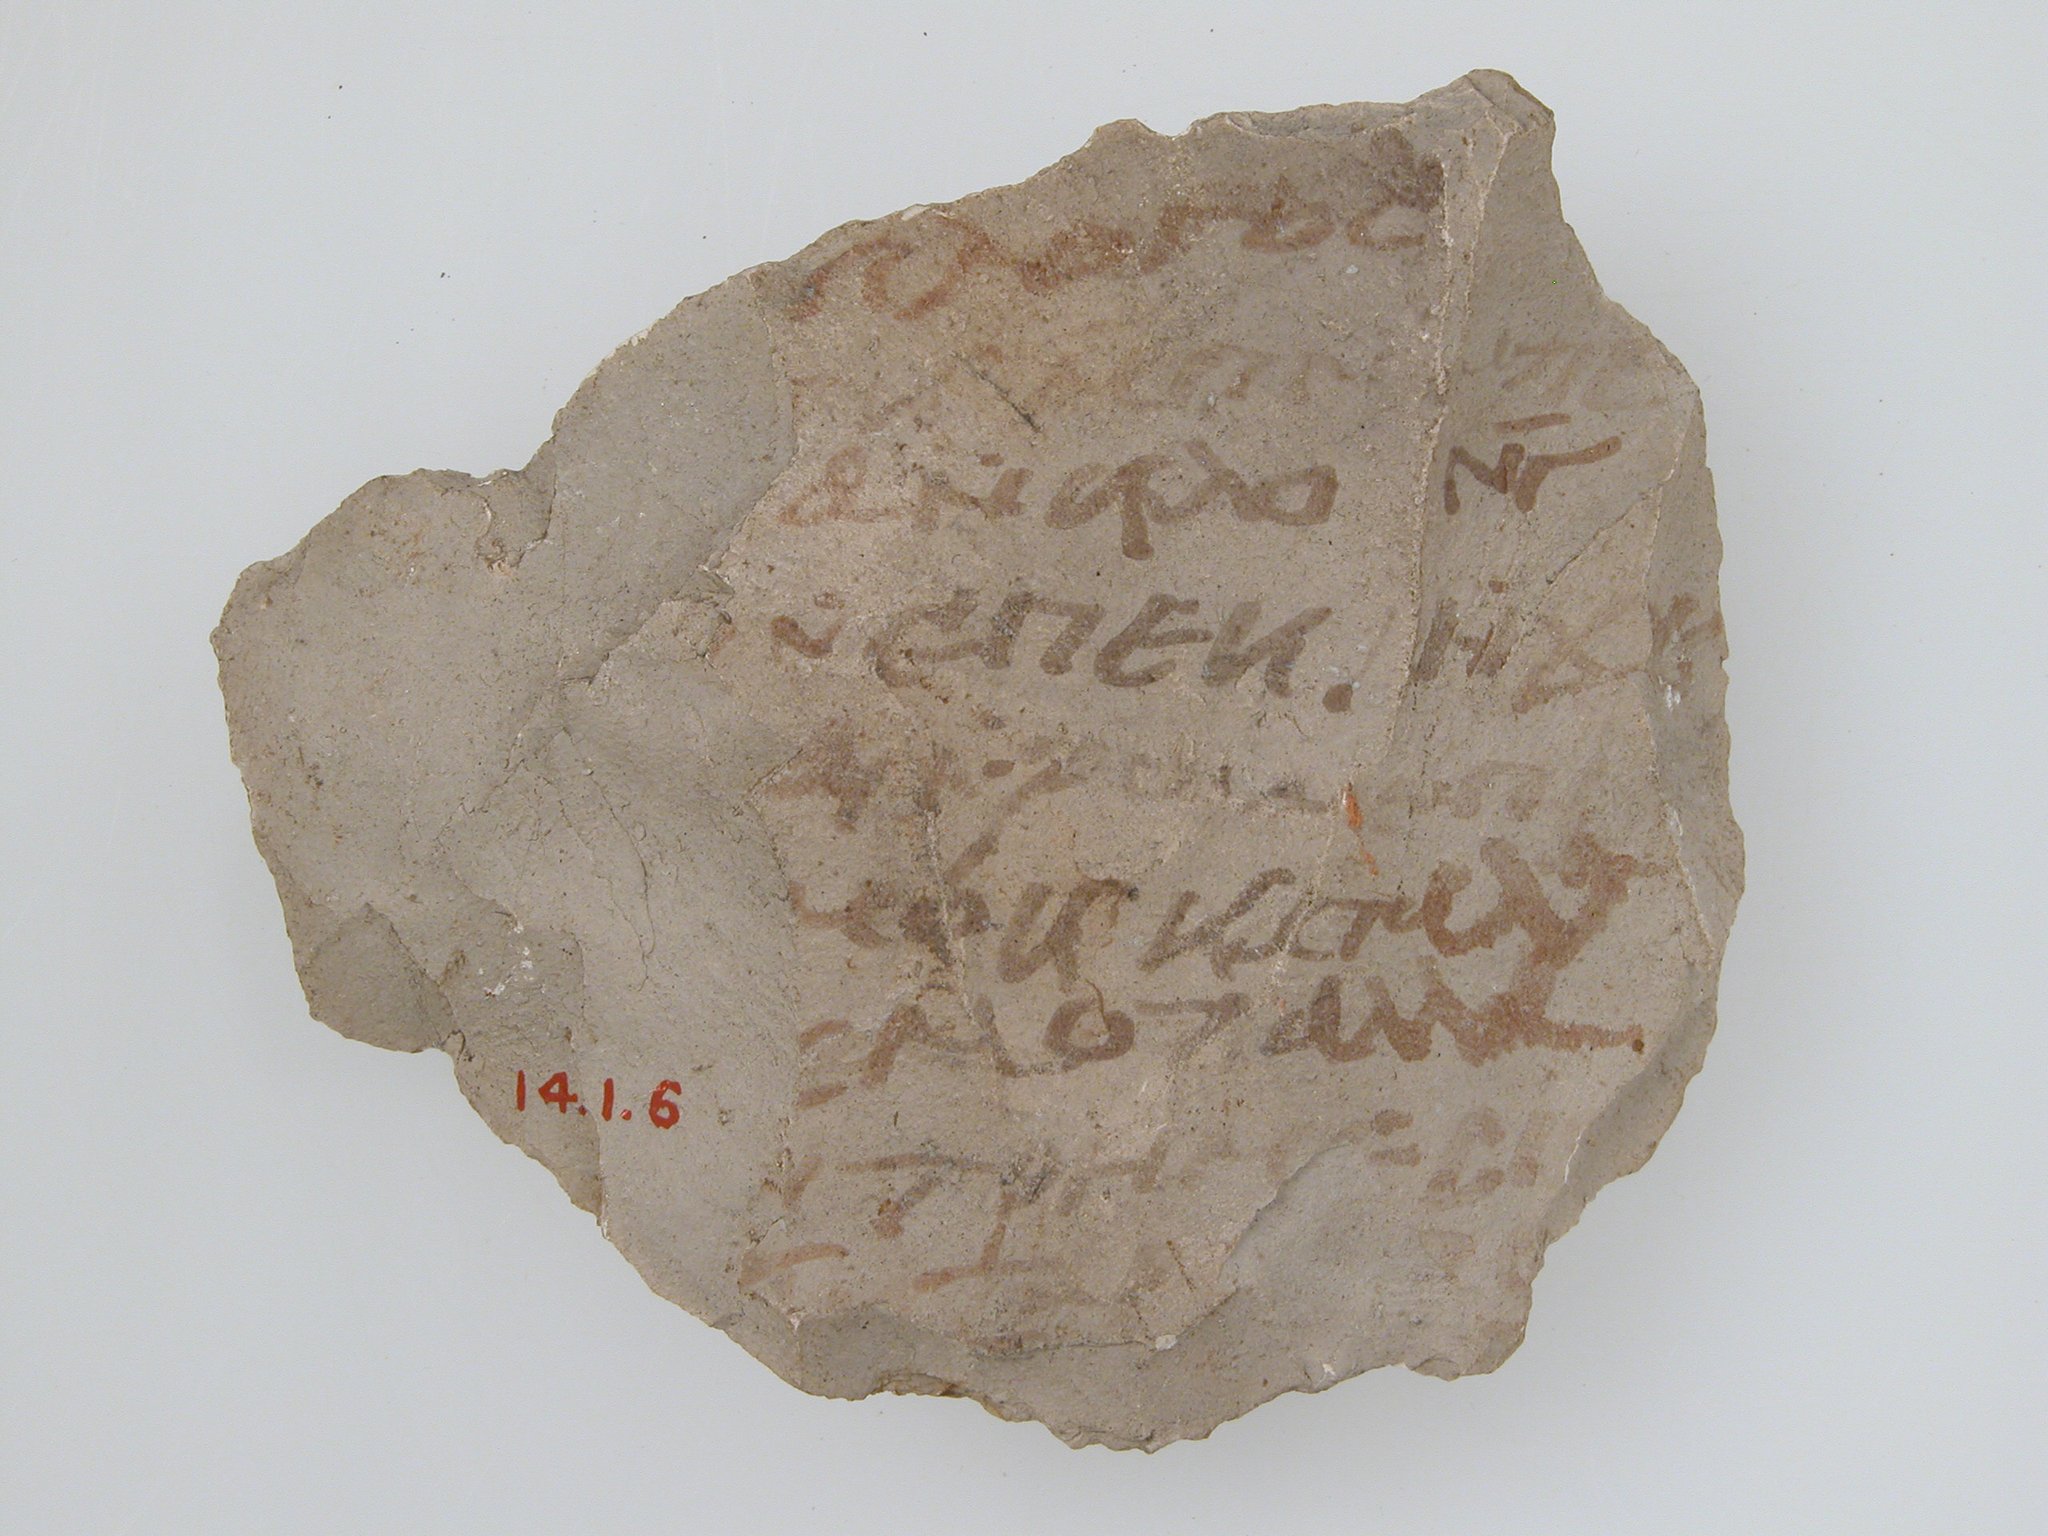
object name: ostrakon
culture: coptic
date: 600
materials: ink, limestone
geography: egypt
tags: coptic,documents